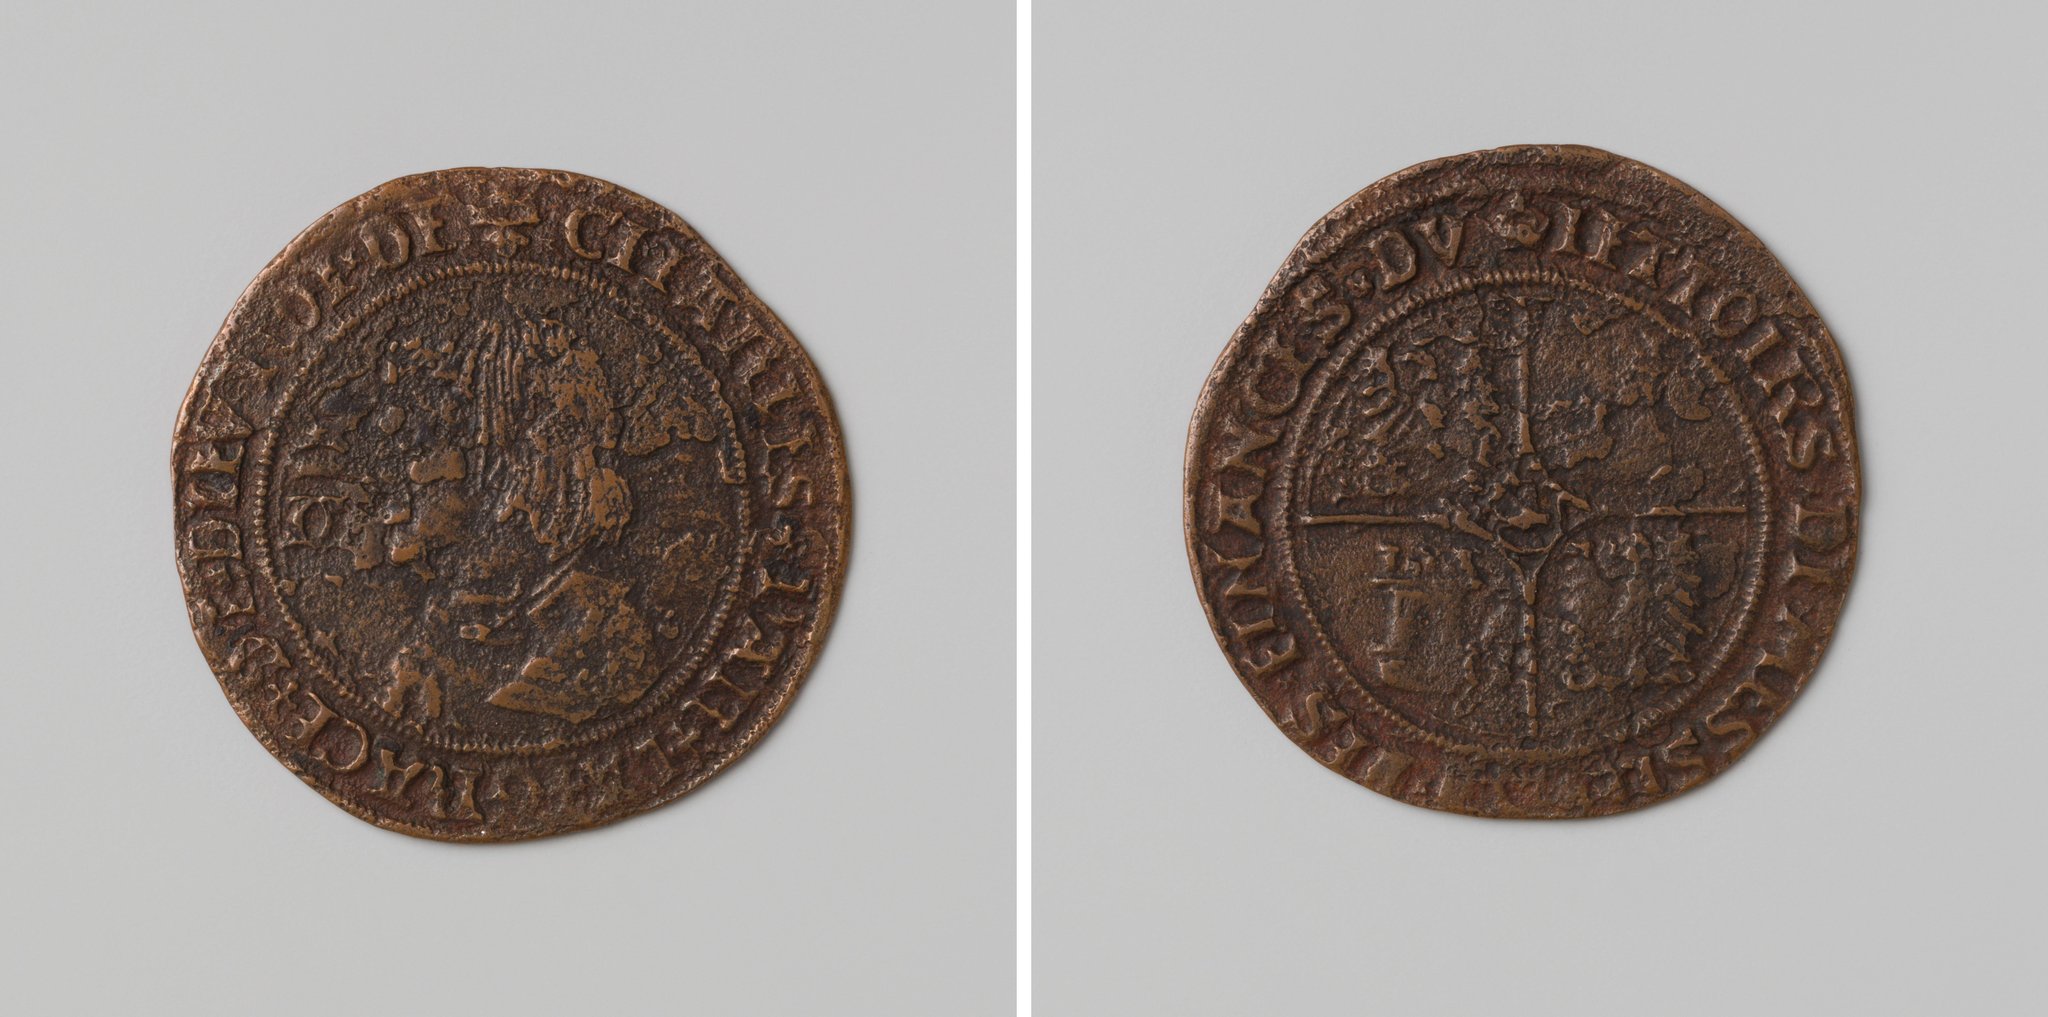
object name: jeton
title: Karel I, koning van Spanje, tot Duits keizer gekozen, rekenpenning van de raad van Financiën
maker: Anonymous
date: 1520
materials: copper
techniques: striking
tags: ghent, charles v (holy roman emperor and king of spain)